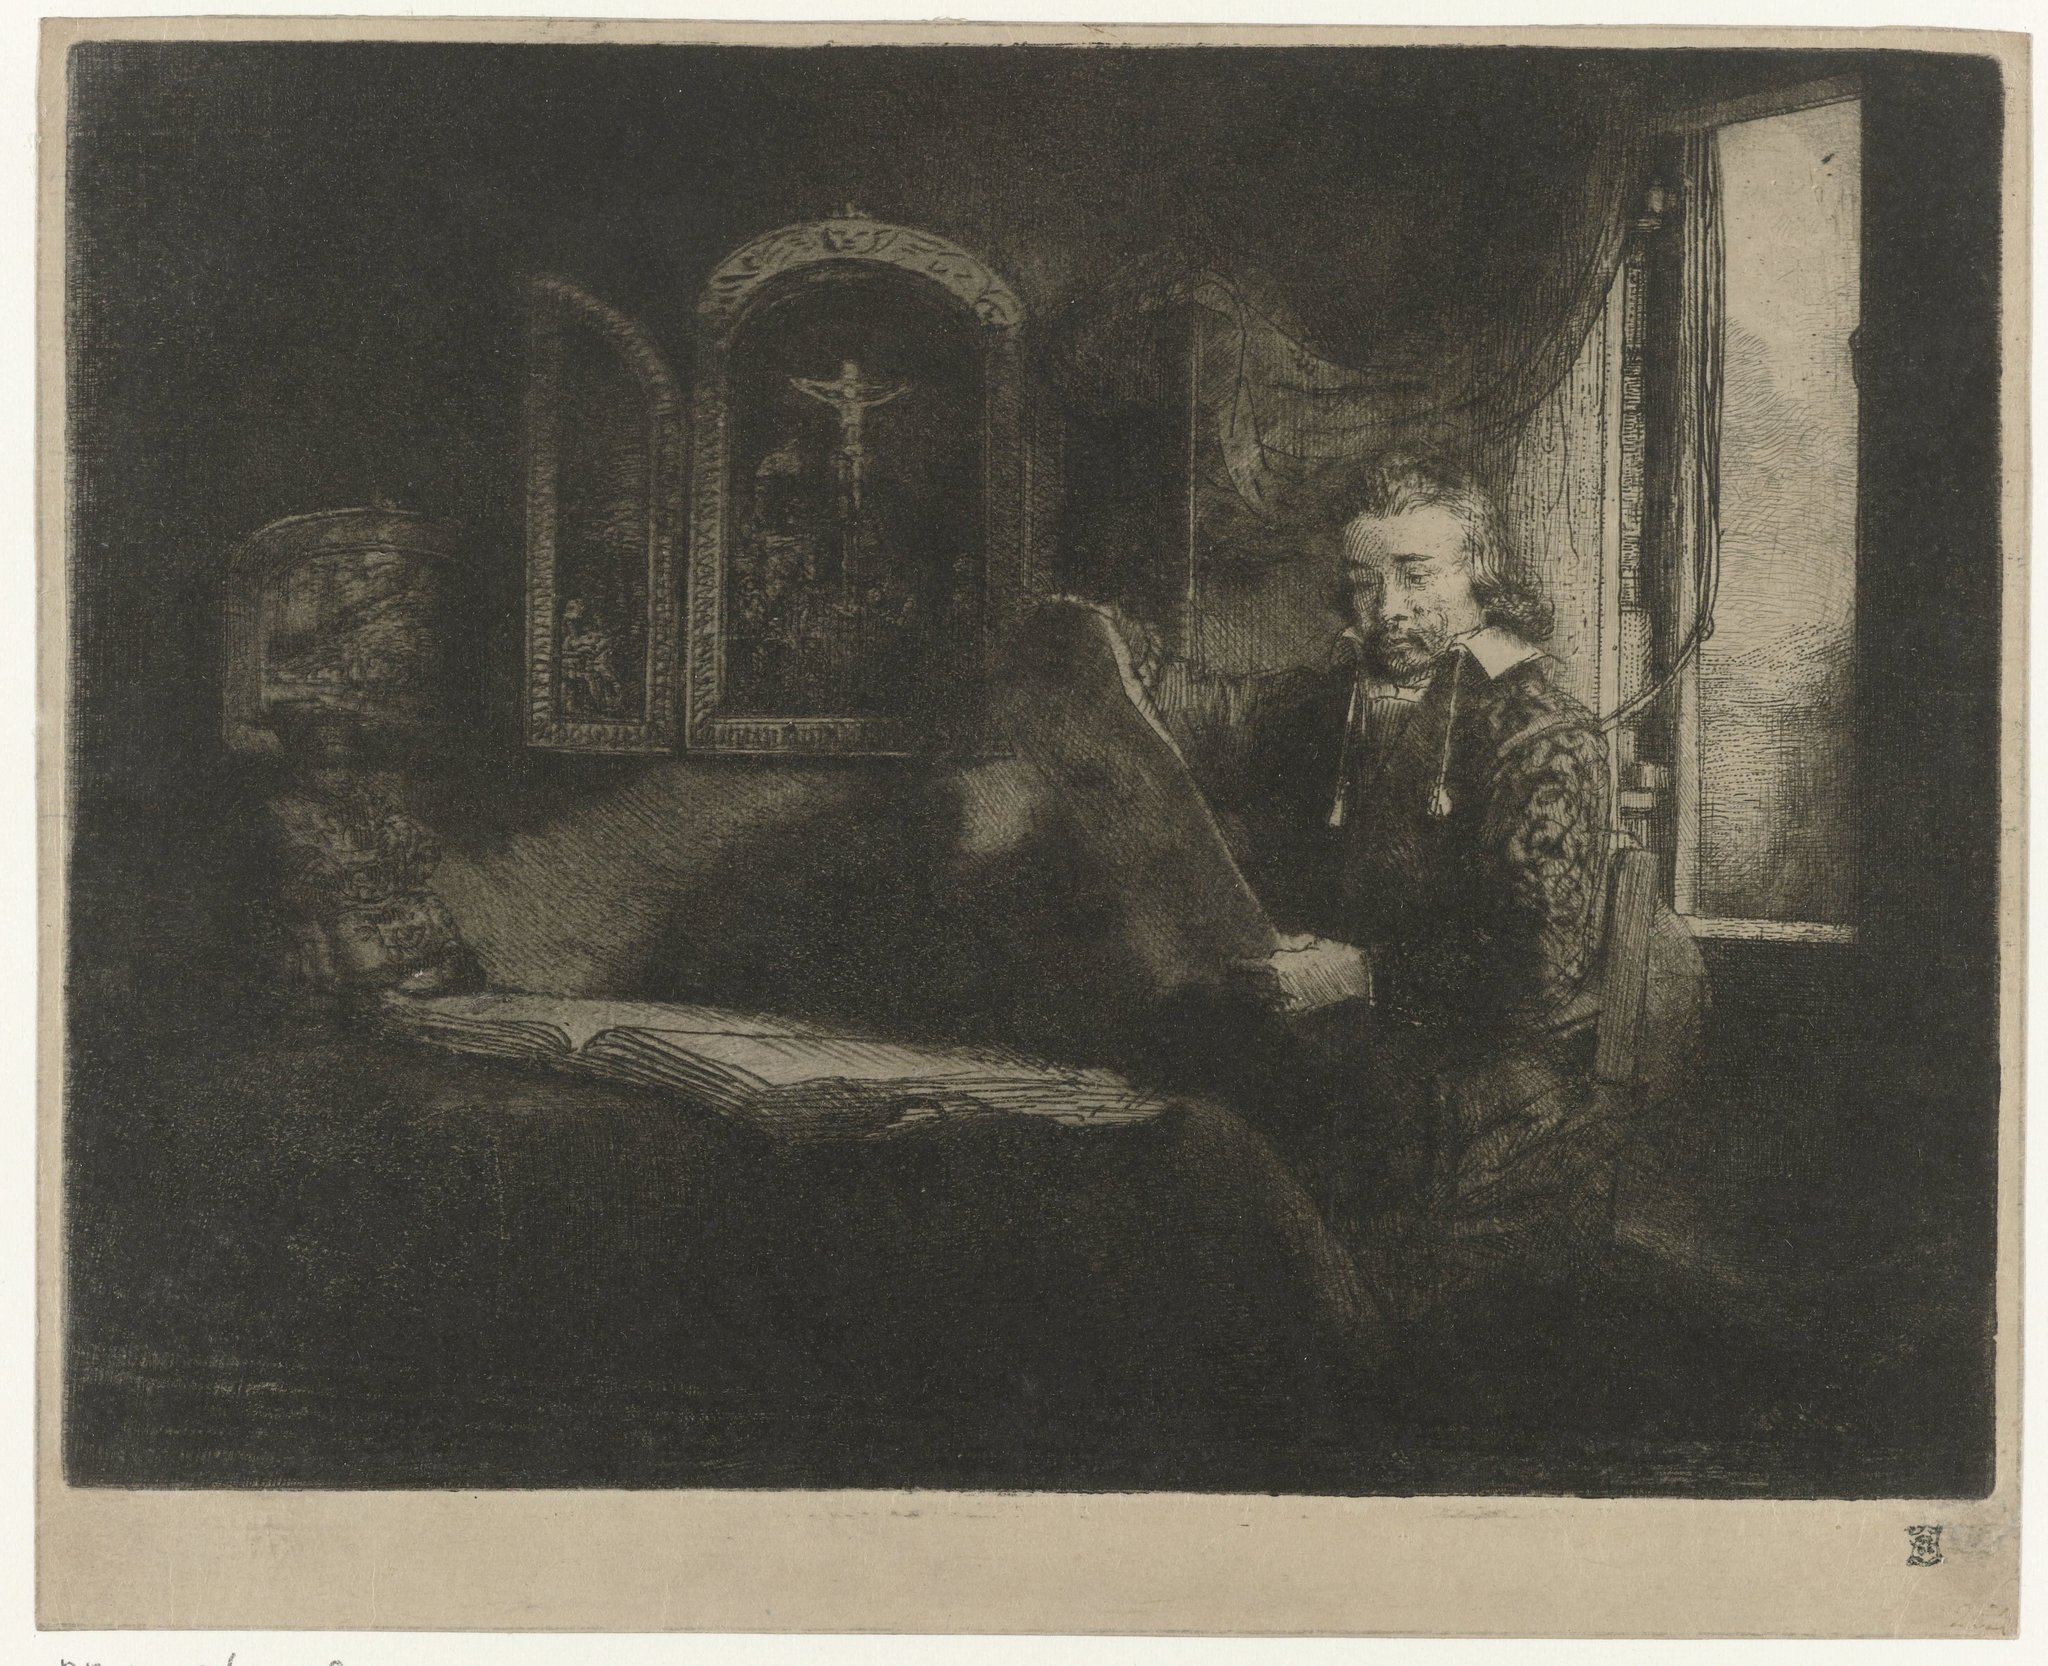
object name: print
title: Portrait of Abraham Francen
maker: rembrandt van rijn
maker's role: draughtsman, painter, print maker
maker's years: 1606-1669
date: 1657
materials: paper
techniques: drypoint, etching, intaglio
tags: kunstverzamelaar, apotheker, abraham francen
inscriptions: mark: Lugt 2849, mark: Lugt 1419, inscription: ‘2nd / Traces of the leg (...) of chair -’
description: Rembrandt portrayed his friend, the apothecary Abraham Francen, in his study. The view of the outside world intruding through the window contrasts with Francen’s concentrated examination of the print or drawing in the quiet solitude of the dark room. The informal mood of the etching is enhanced by Francen’s unbuttoned doublet and the nonchalantly draped curtain.